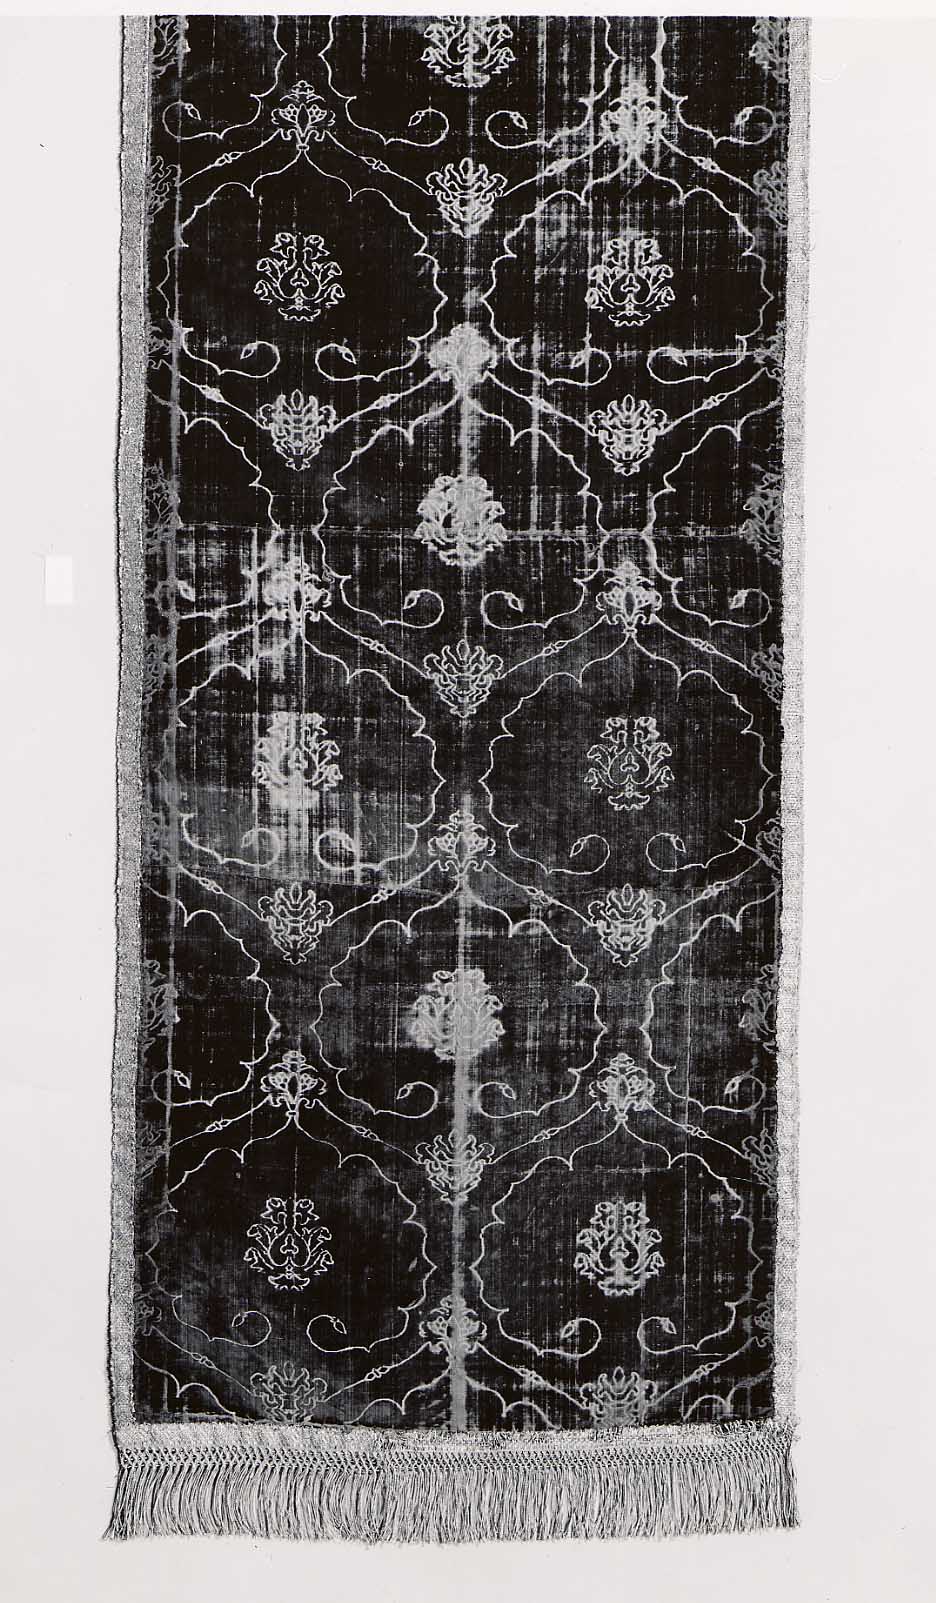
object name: cover or hanging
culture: italian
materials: silk, velvet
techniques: cutting, weave, voiding